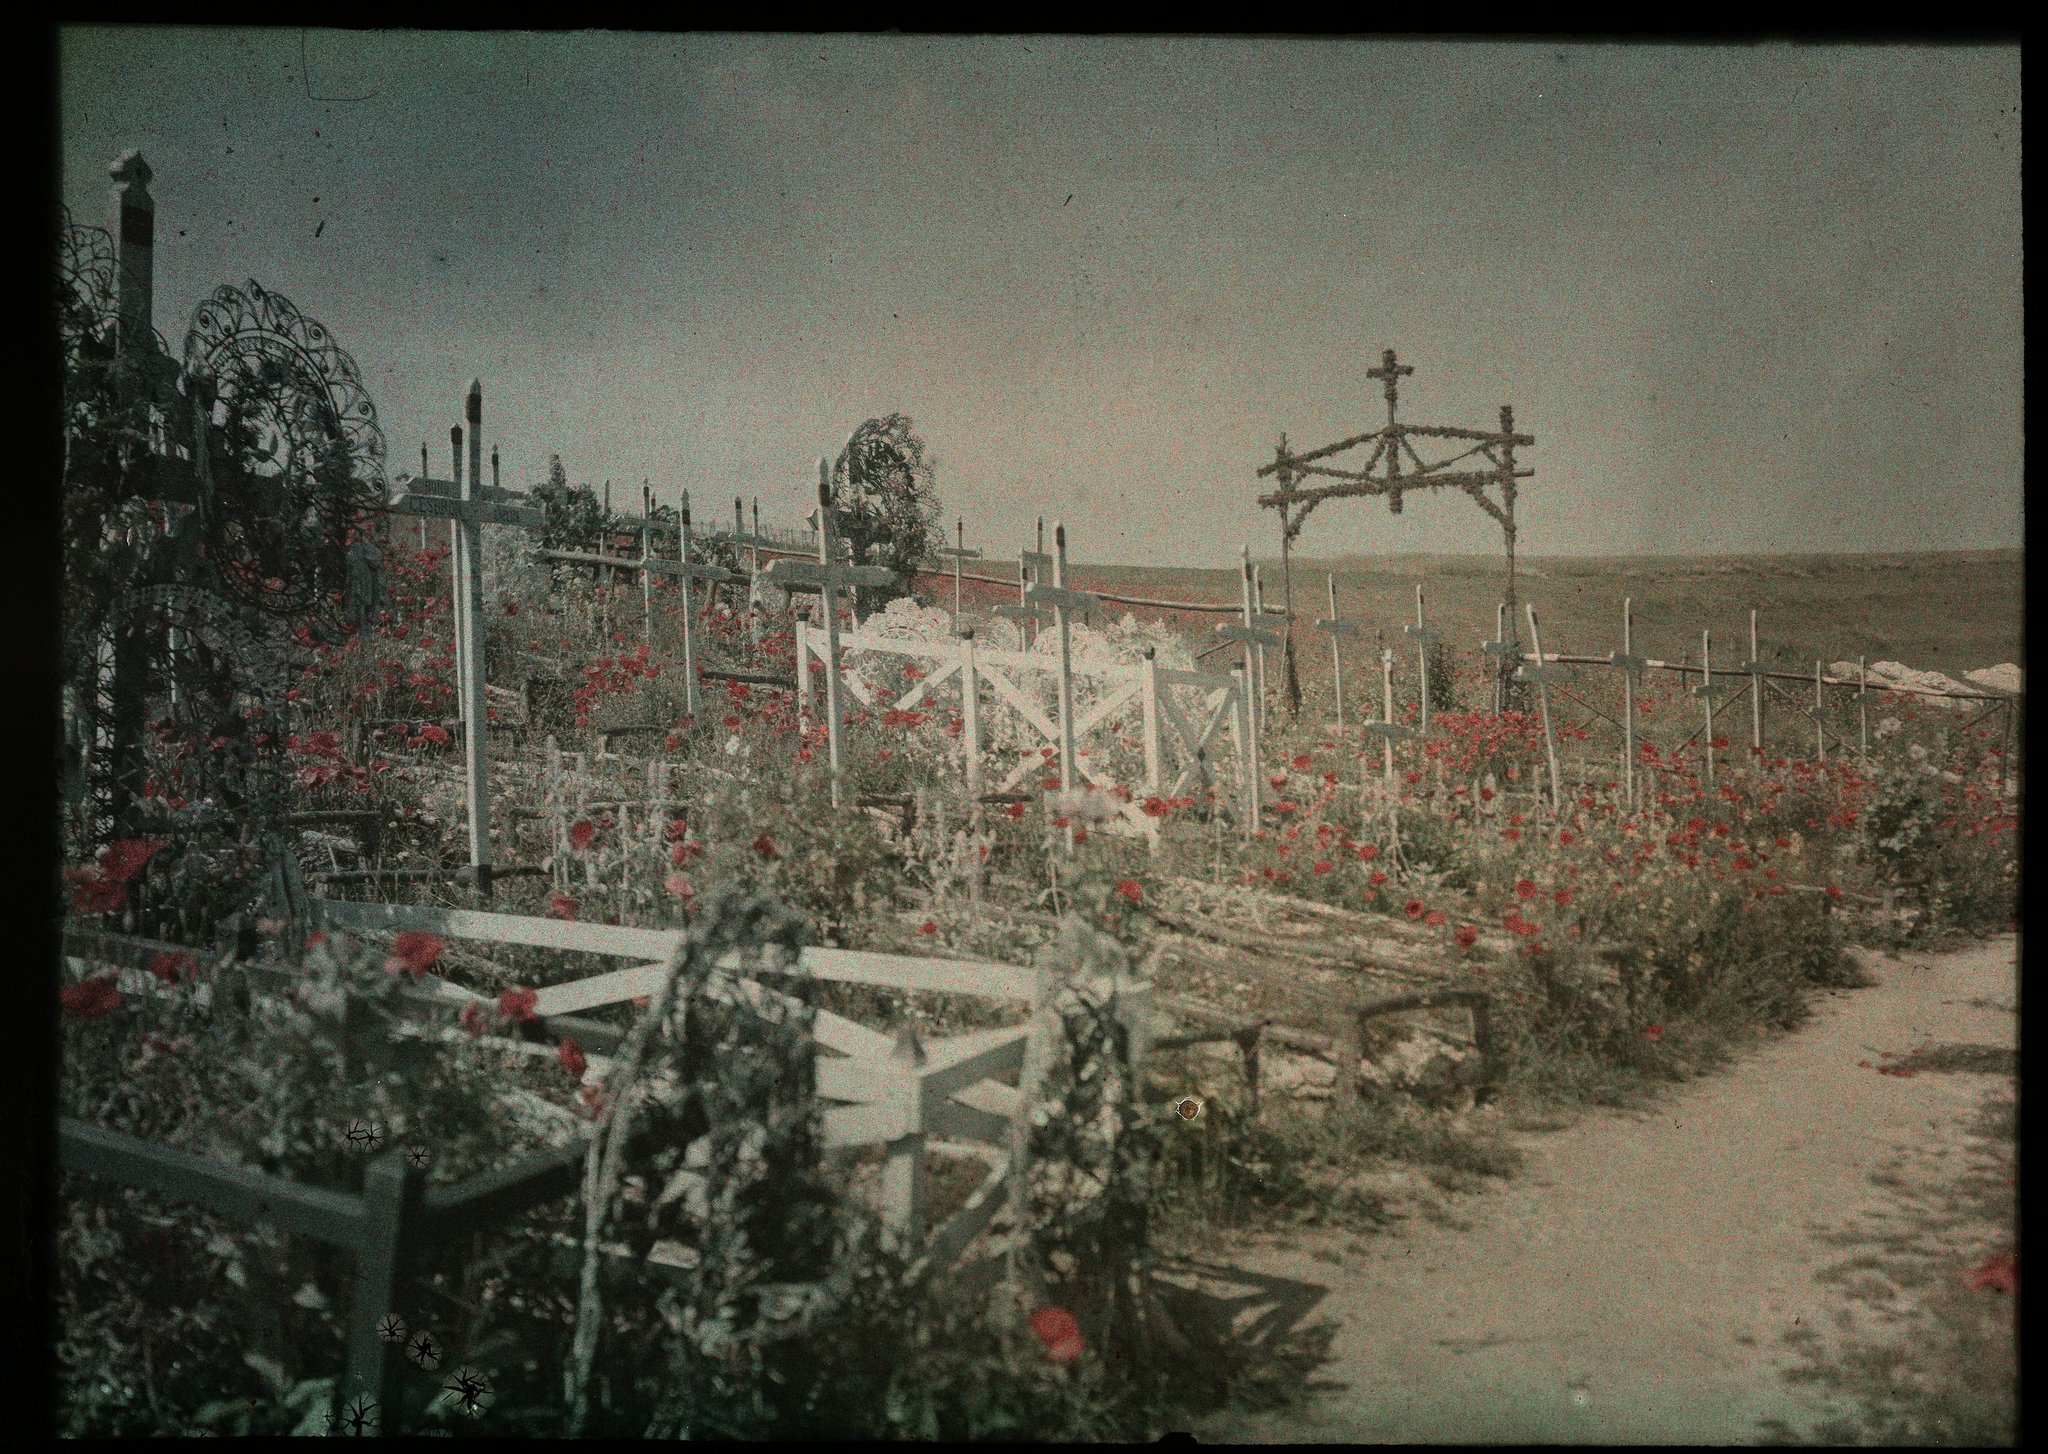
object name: photograph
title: Kerkhof met klaprozen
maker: Anonymous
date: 1914-1918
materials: glass, paper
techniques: autochrome process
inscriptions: : ‘.’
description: Kerkhof met papavers tijdens de Eerste Wereldoorlog. Namen Cesbron, Bono en Lepley op graven leesbaar (in Frankrijk?).